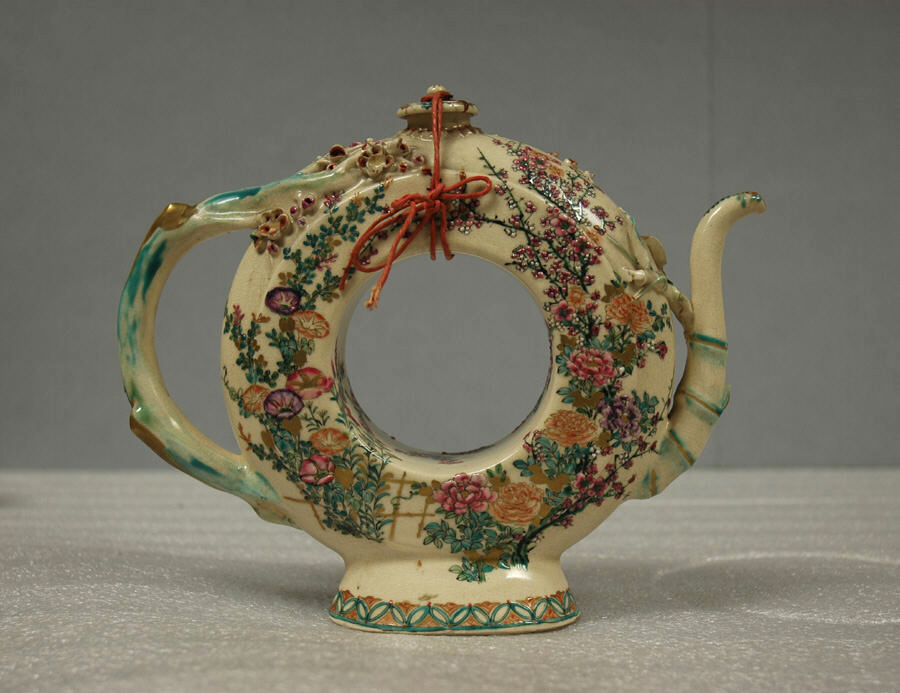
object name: wine pot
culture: japanese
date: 1860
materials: clay, enamel, glaze, gold